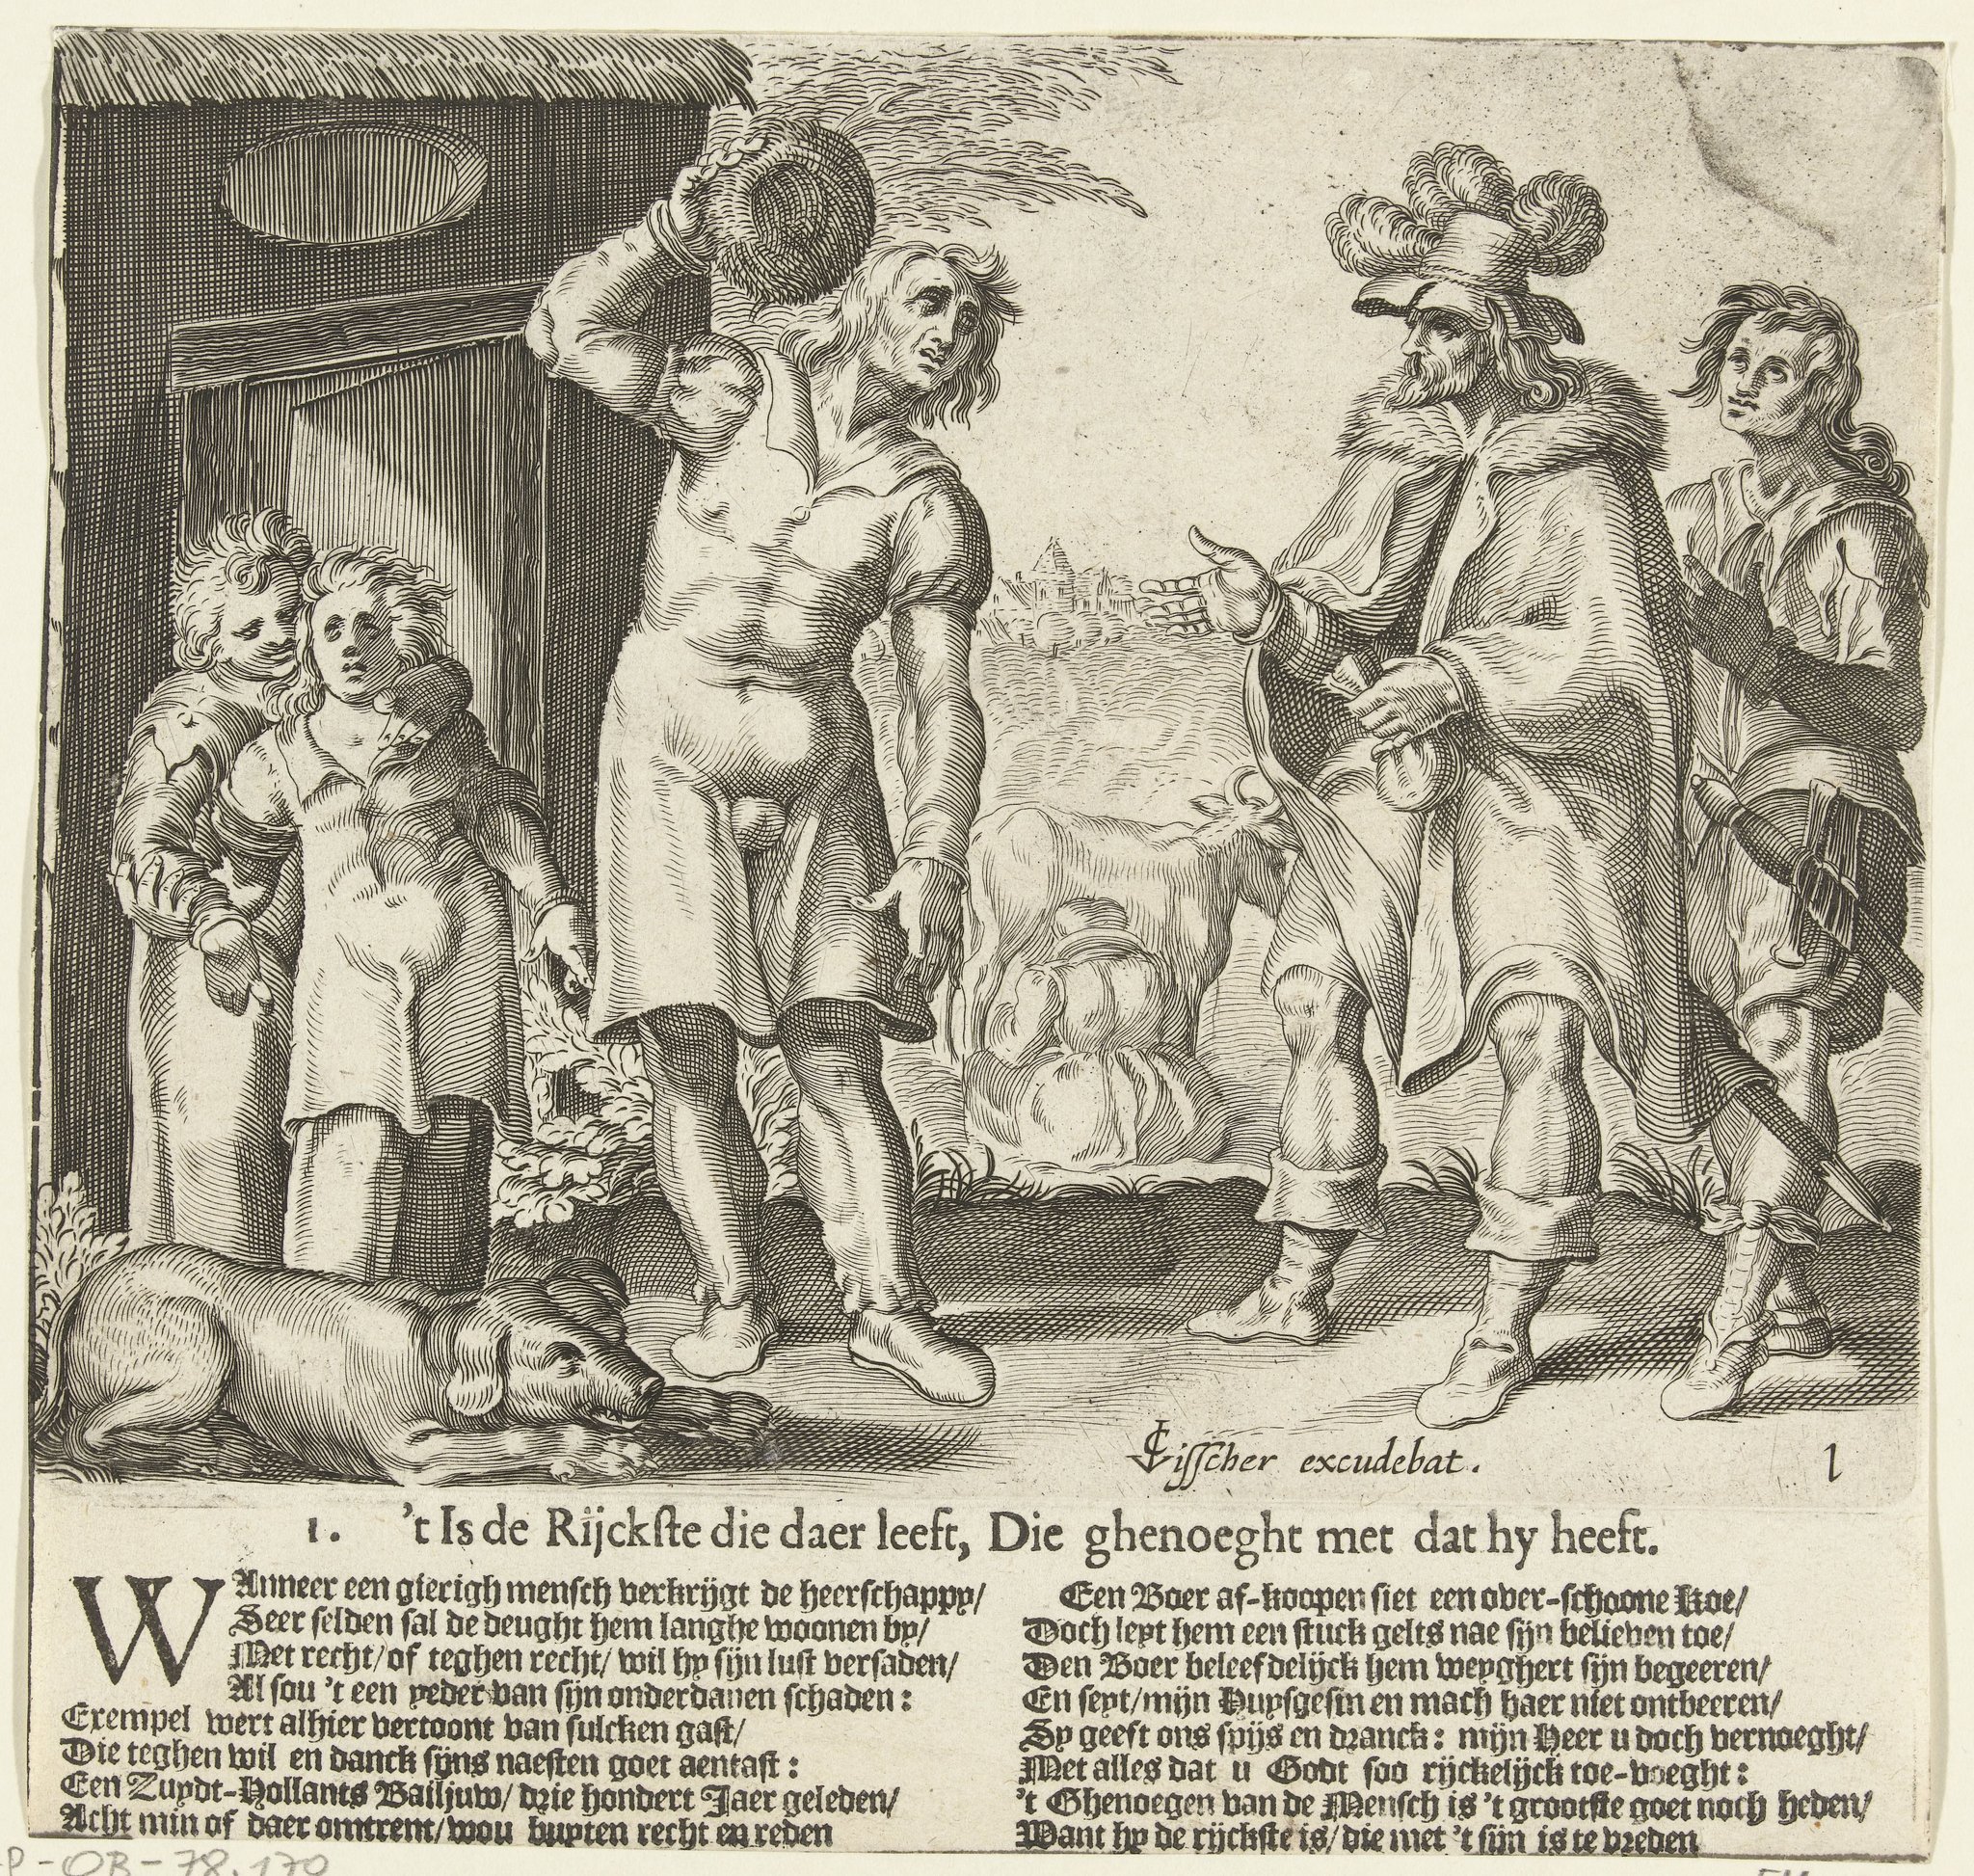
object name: history print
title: 1. 't Is de Rijckste die daer leeft, Die ghenoeght met dat hy heeft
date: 1613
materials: paper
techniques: engraving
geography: northern netherlands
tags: willem iii de goede (graaf van holland en henegouwen), cow, netherlands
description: De baljuw probeert de koe van de boer te kopen. Rechts de baljuw van Zuid-Holland met een zak geld, links de boer en zijn gezin. Op de achtergrond wordt de koe door de boerin gemolken. Voorstelling nr. 1 in een serie van zes kleine scènes van de opeenvolgende episoden van het verhaal van de Rechtspraak van graaf Willem III in het jaar 1336. Deze kleine prenten behoren aan weerszijden van de grote centrale voorstelling. Bij elke voorstelling een onderschrift bestaande uit een spreuk en een vers van twee kolommen van acht regels.